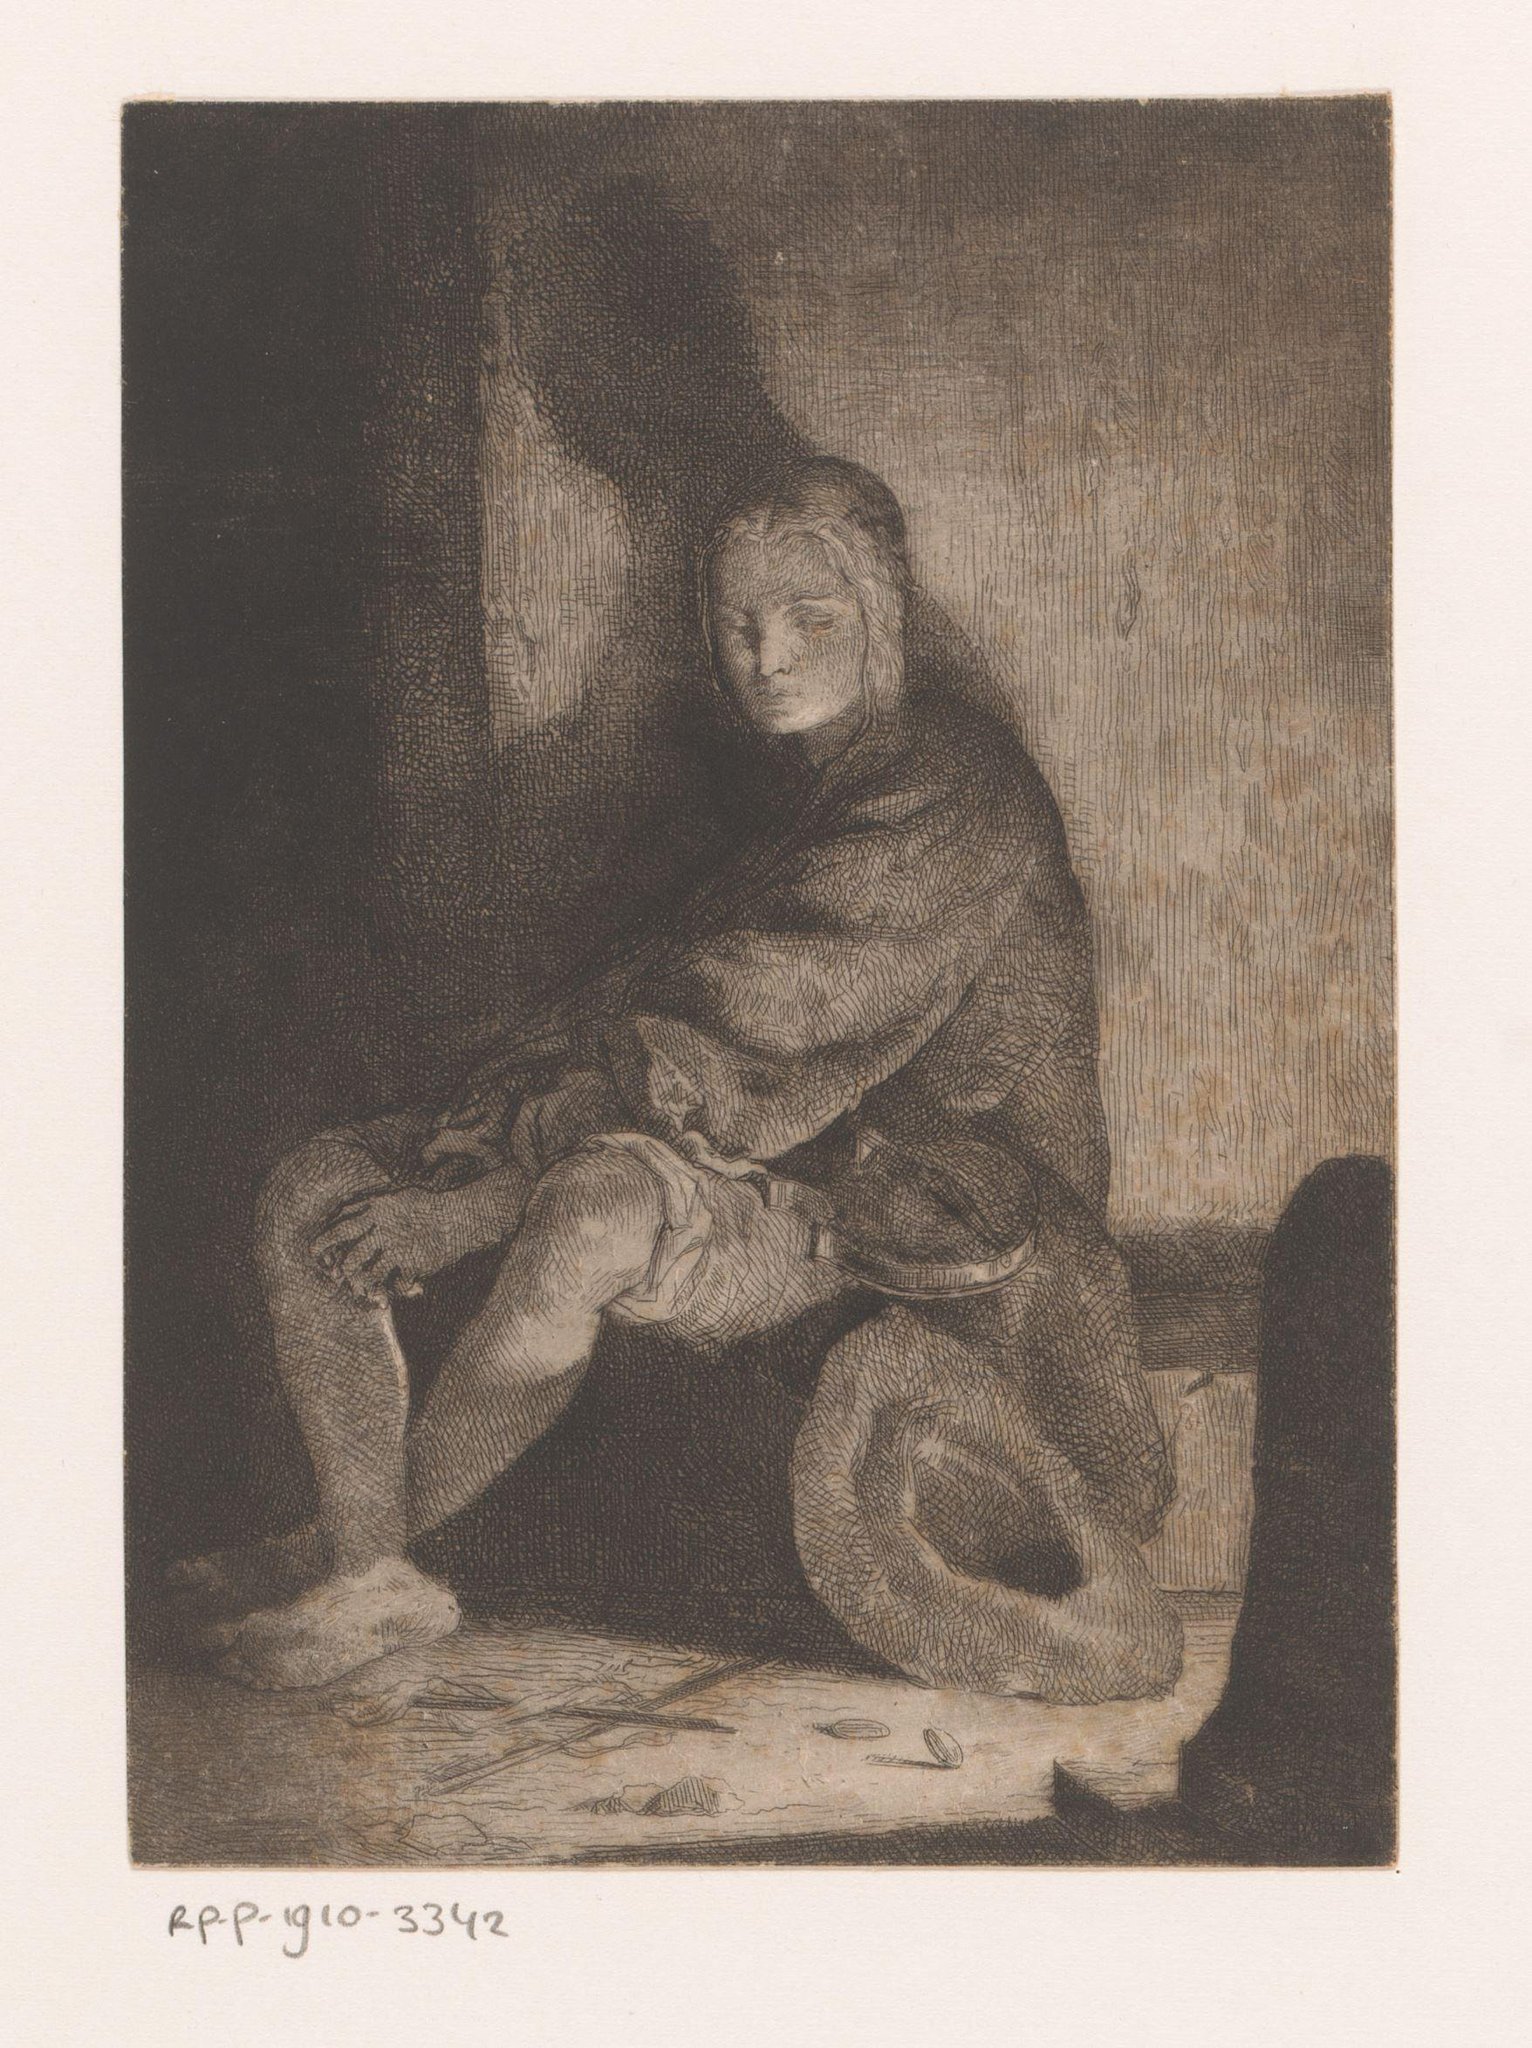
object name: print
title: Jongeling met viool op schoot en de strijkstok gebroken op de grond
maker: louis gallait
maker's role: draughtsman, painter, print maker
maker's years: 1810-1887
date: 1865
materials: paper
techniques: etching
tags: sitting figure, violin, fiddle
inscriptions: collector's mark: Lugt 1485, collector's mark: Lugt 2228